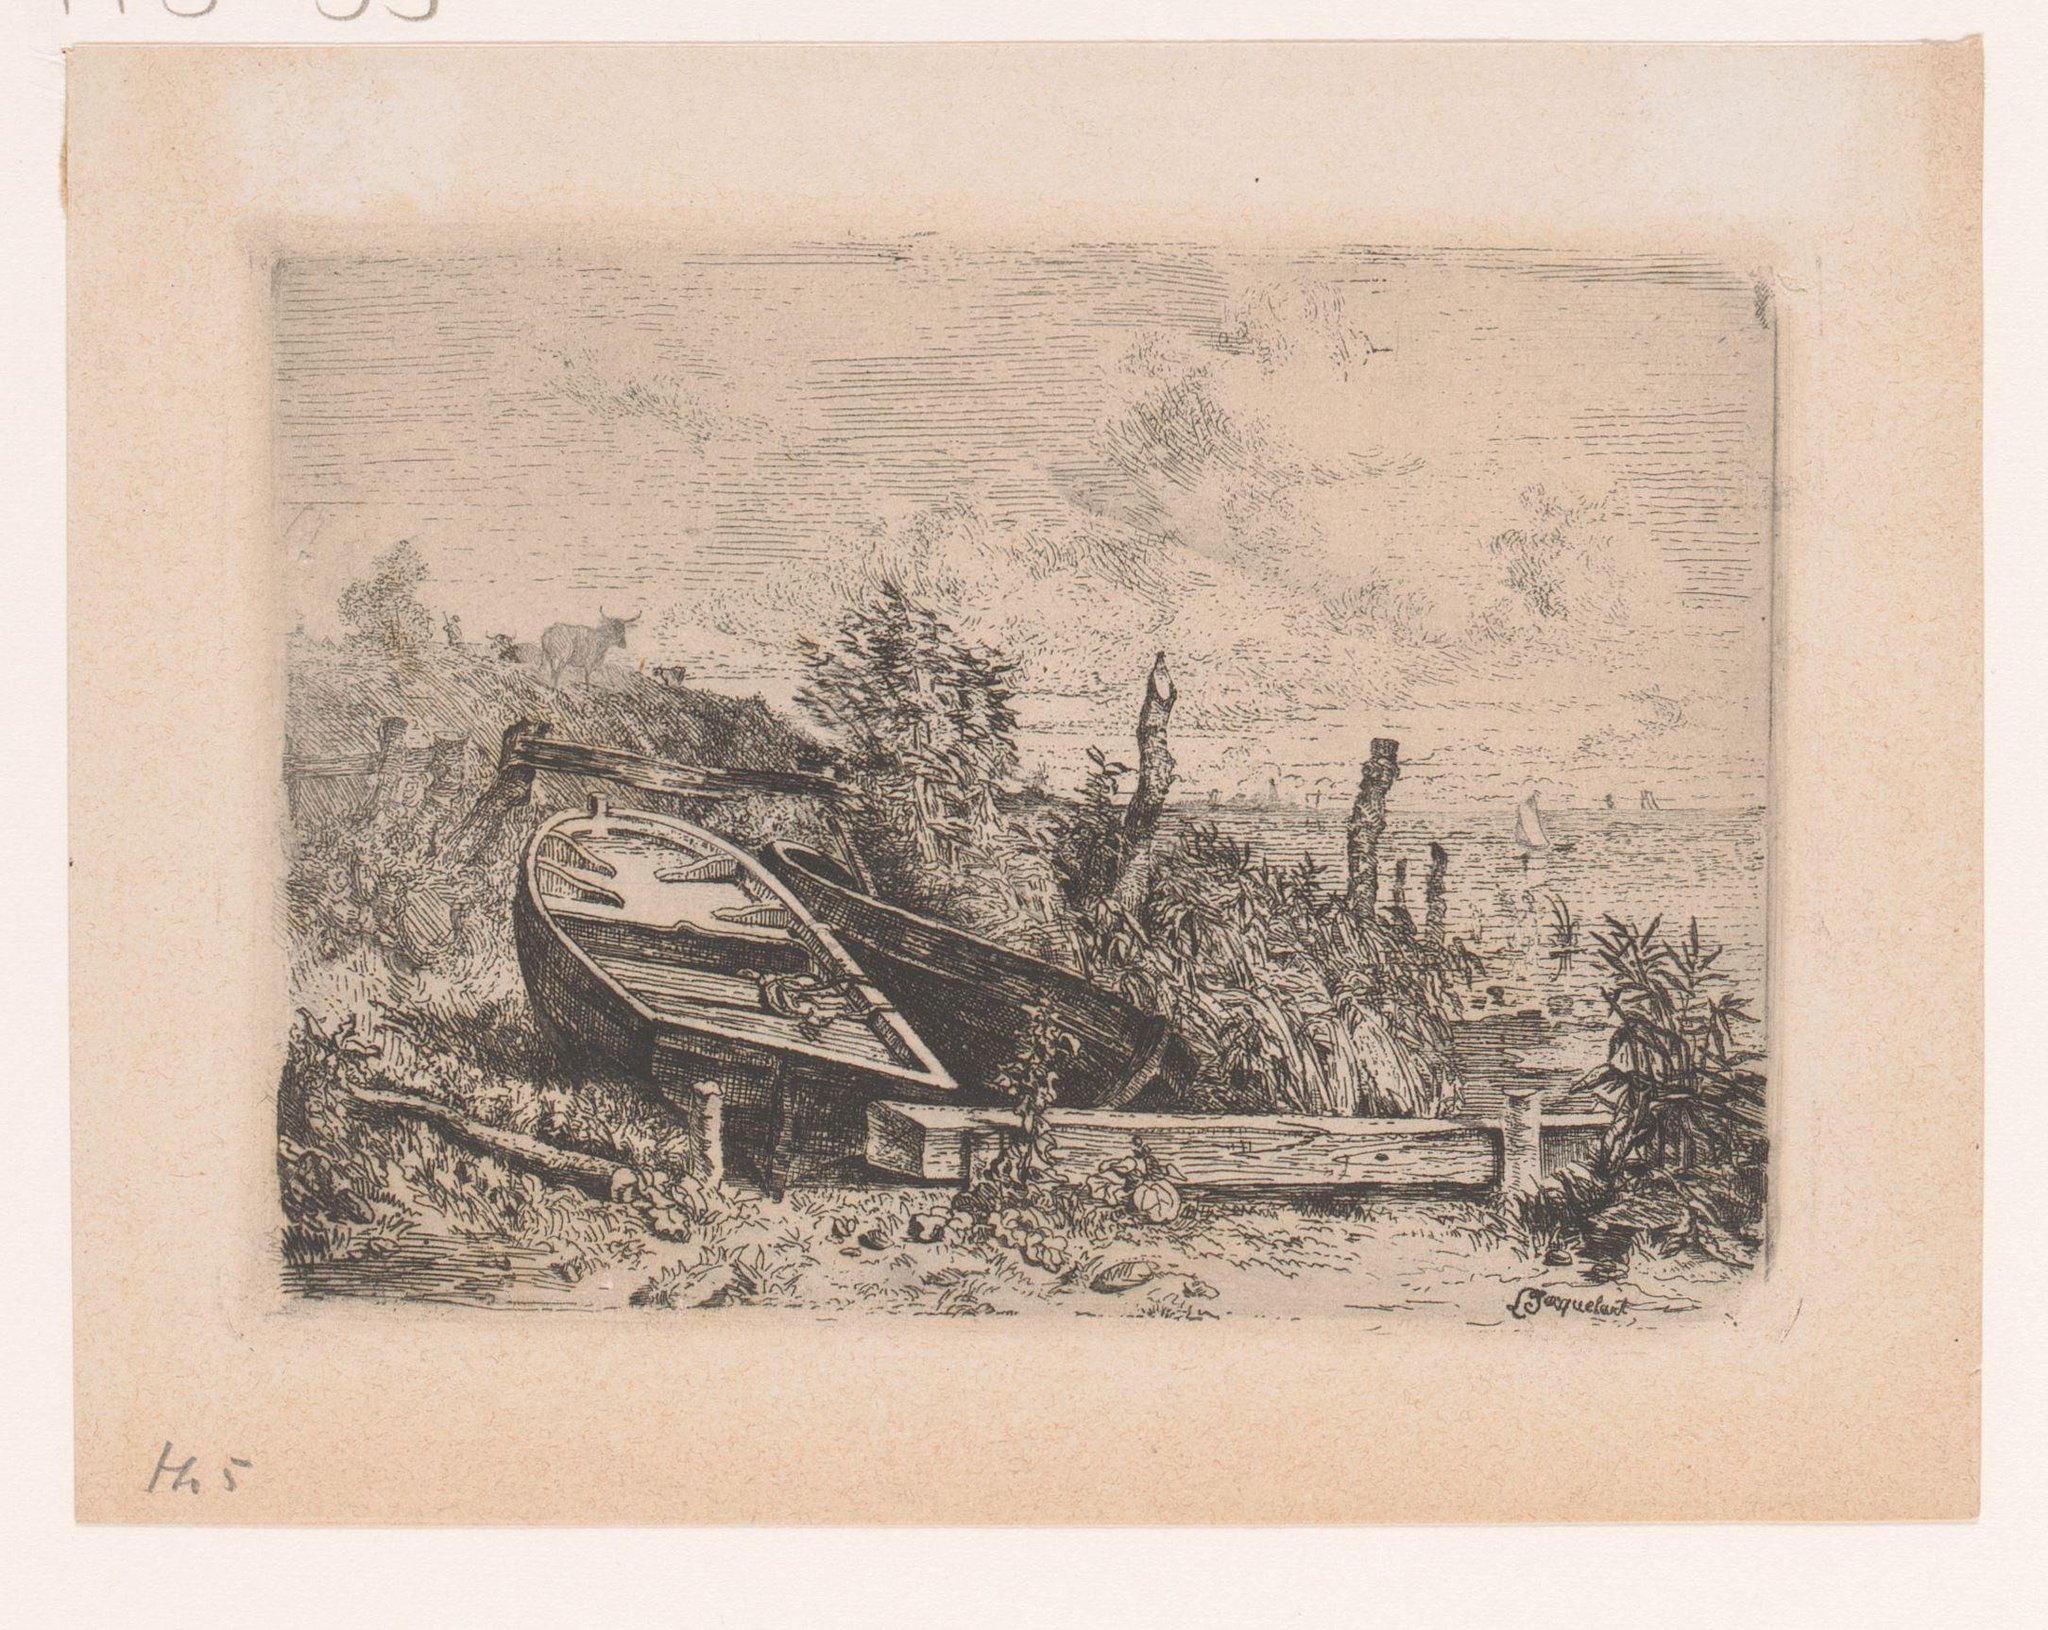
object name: print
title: Twee roeiboten op de kant naast een rivier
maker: lambert jacquelart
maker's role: print maker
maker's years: 1820-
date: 1830-1910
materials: paper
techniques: etching, intaglio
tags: river, rowing-boat, canoe, etc.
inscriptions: collector's mark: Lugt 2228, collector's mark: Lugt 1485